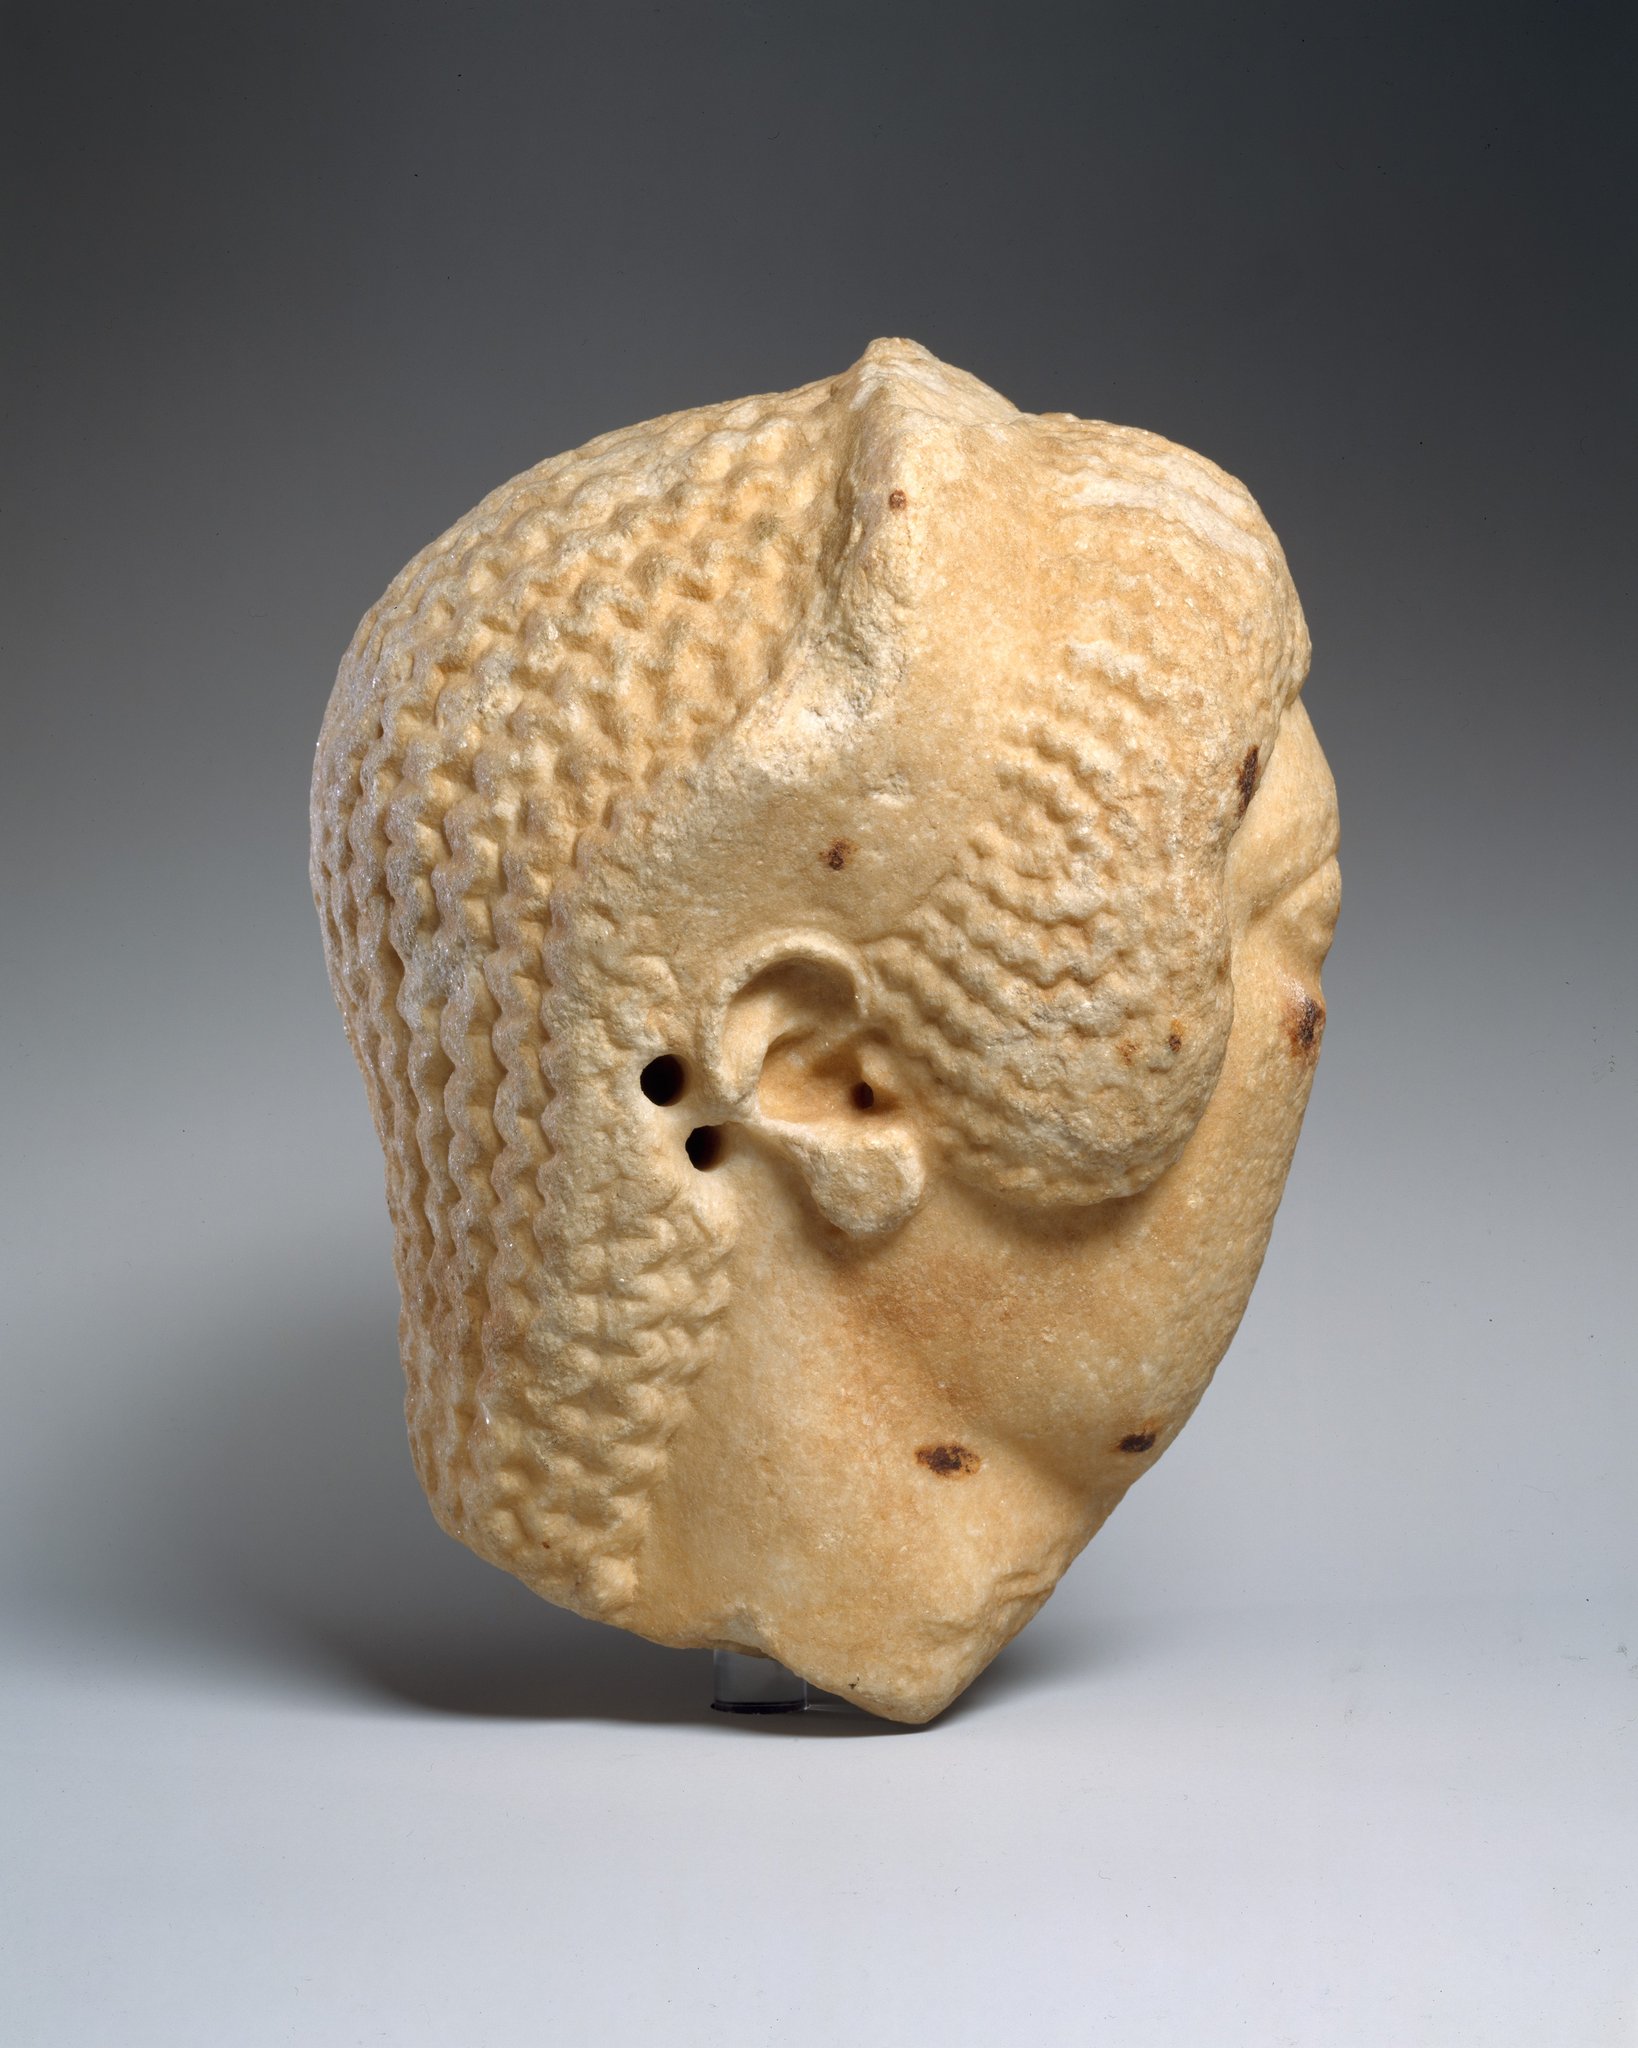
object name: head of a woman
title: Marble head of a woman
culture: greek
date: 534-501 BCE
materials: marble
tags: heads,women